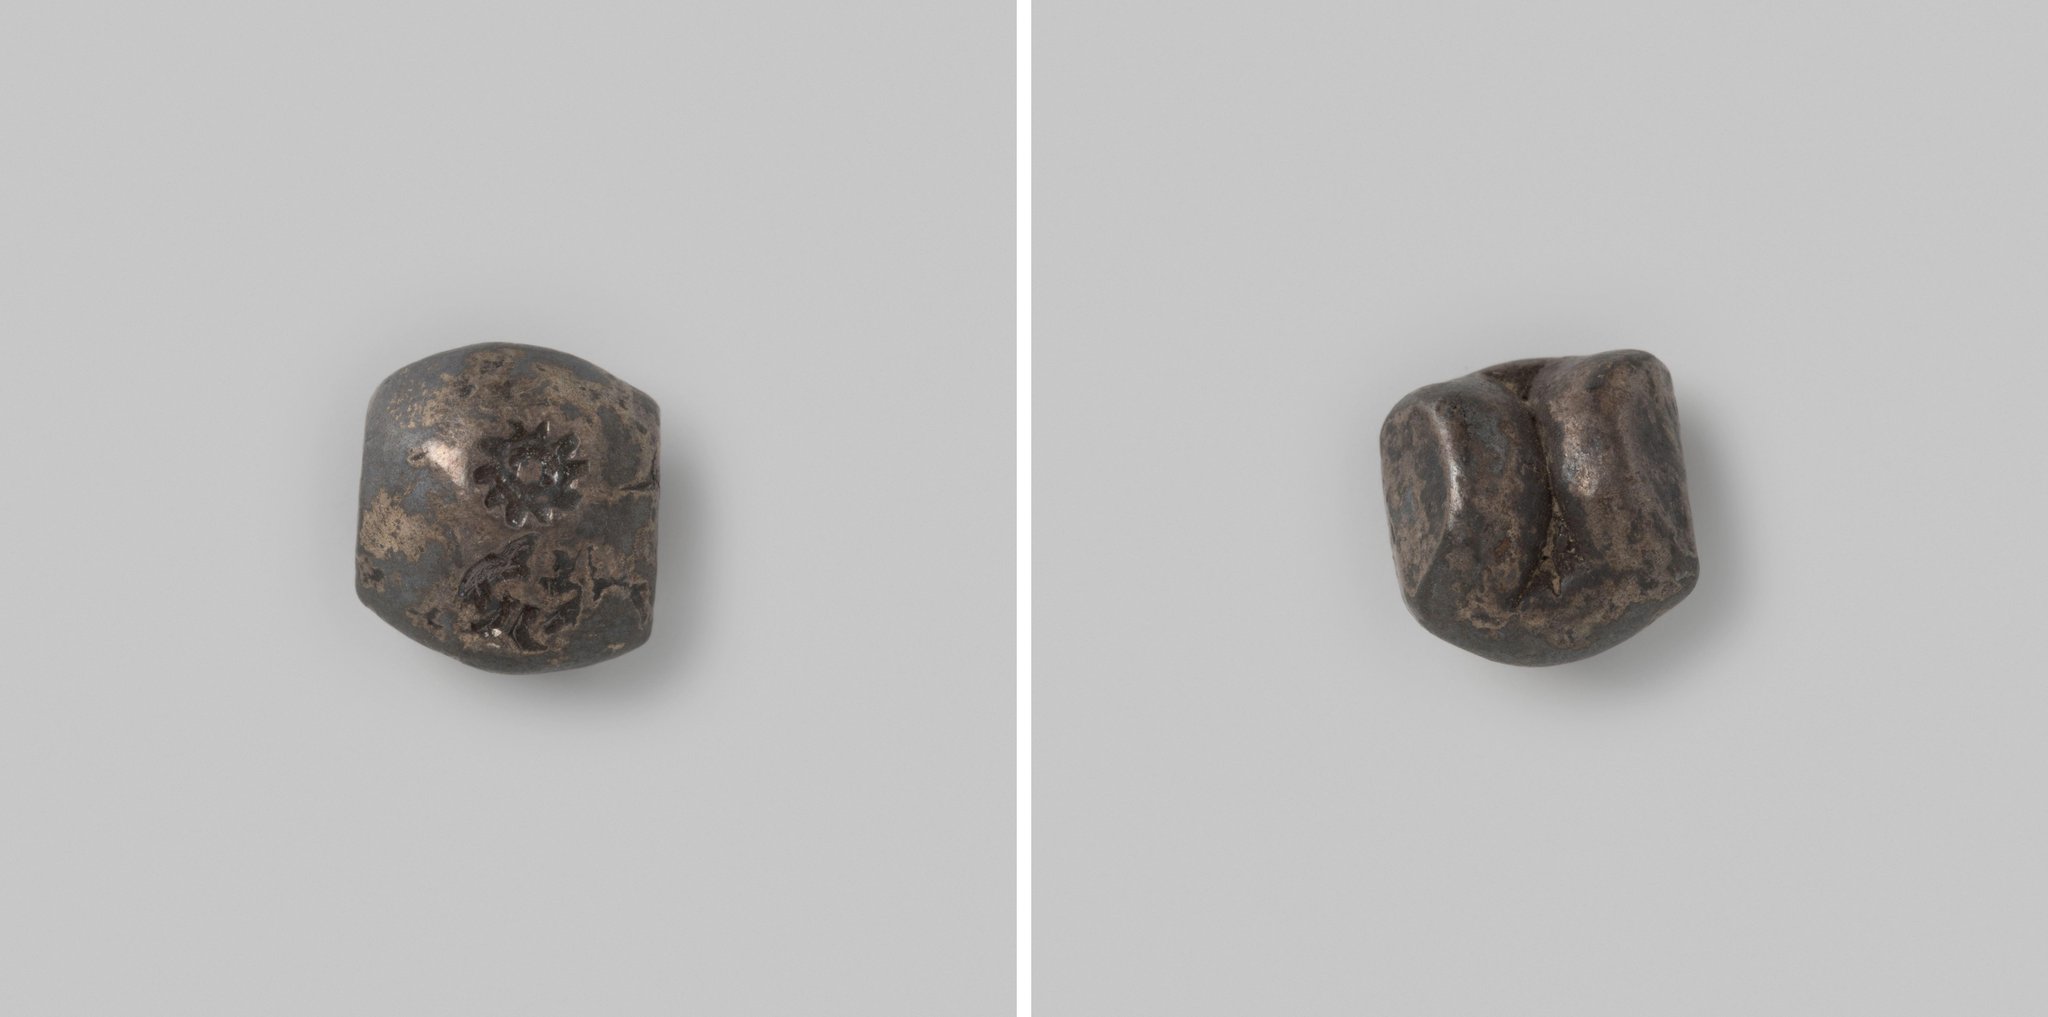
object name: coin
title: Thailand,1/4 tical of salung,1650-1850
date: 1650-1850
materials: silver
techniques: casting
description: Zilveren, korrelvormige munt. voorzien van twee instempelingen (kra): chakra en pagode.